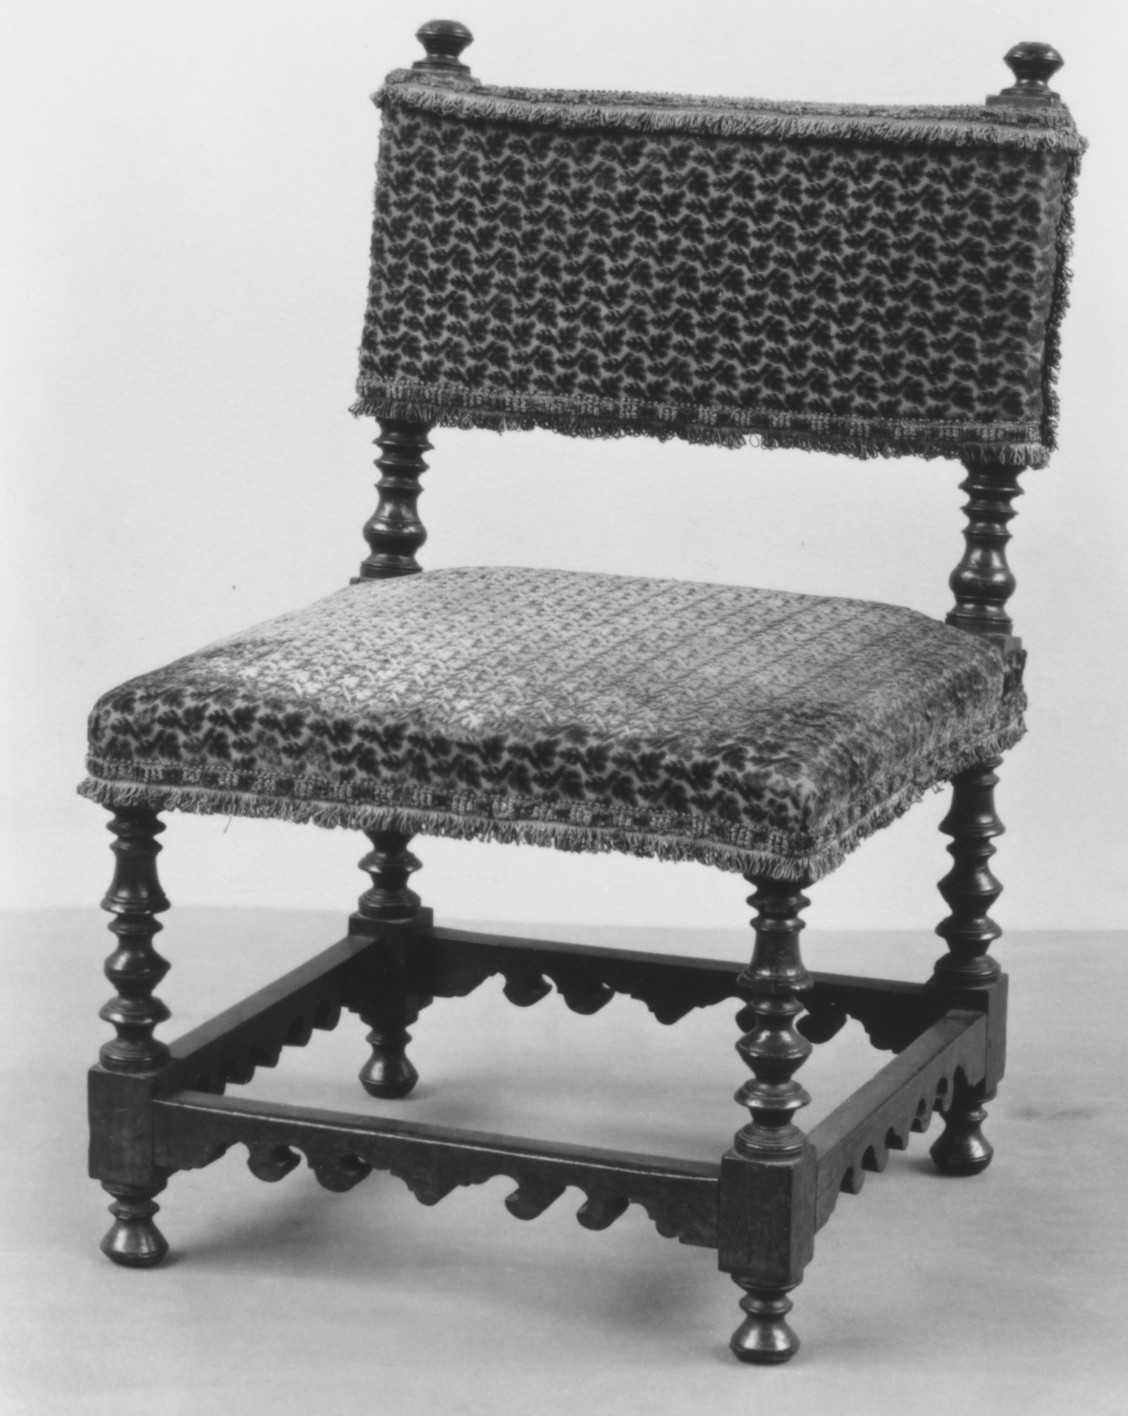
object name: side chair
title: Child's side chair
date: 1601-1650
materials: wood